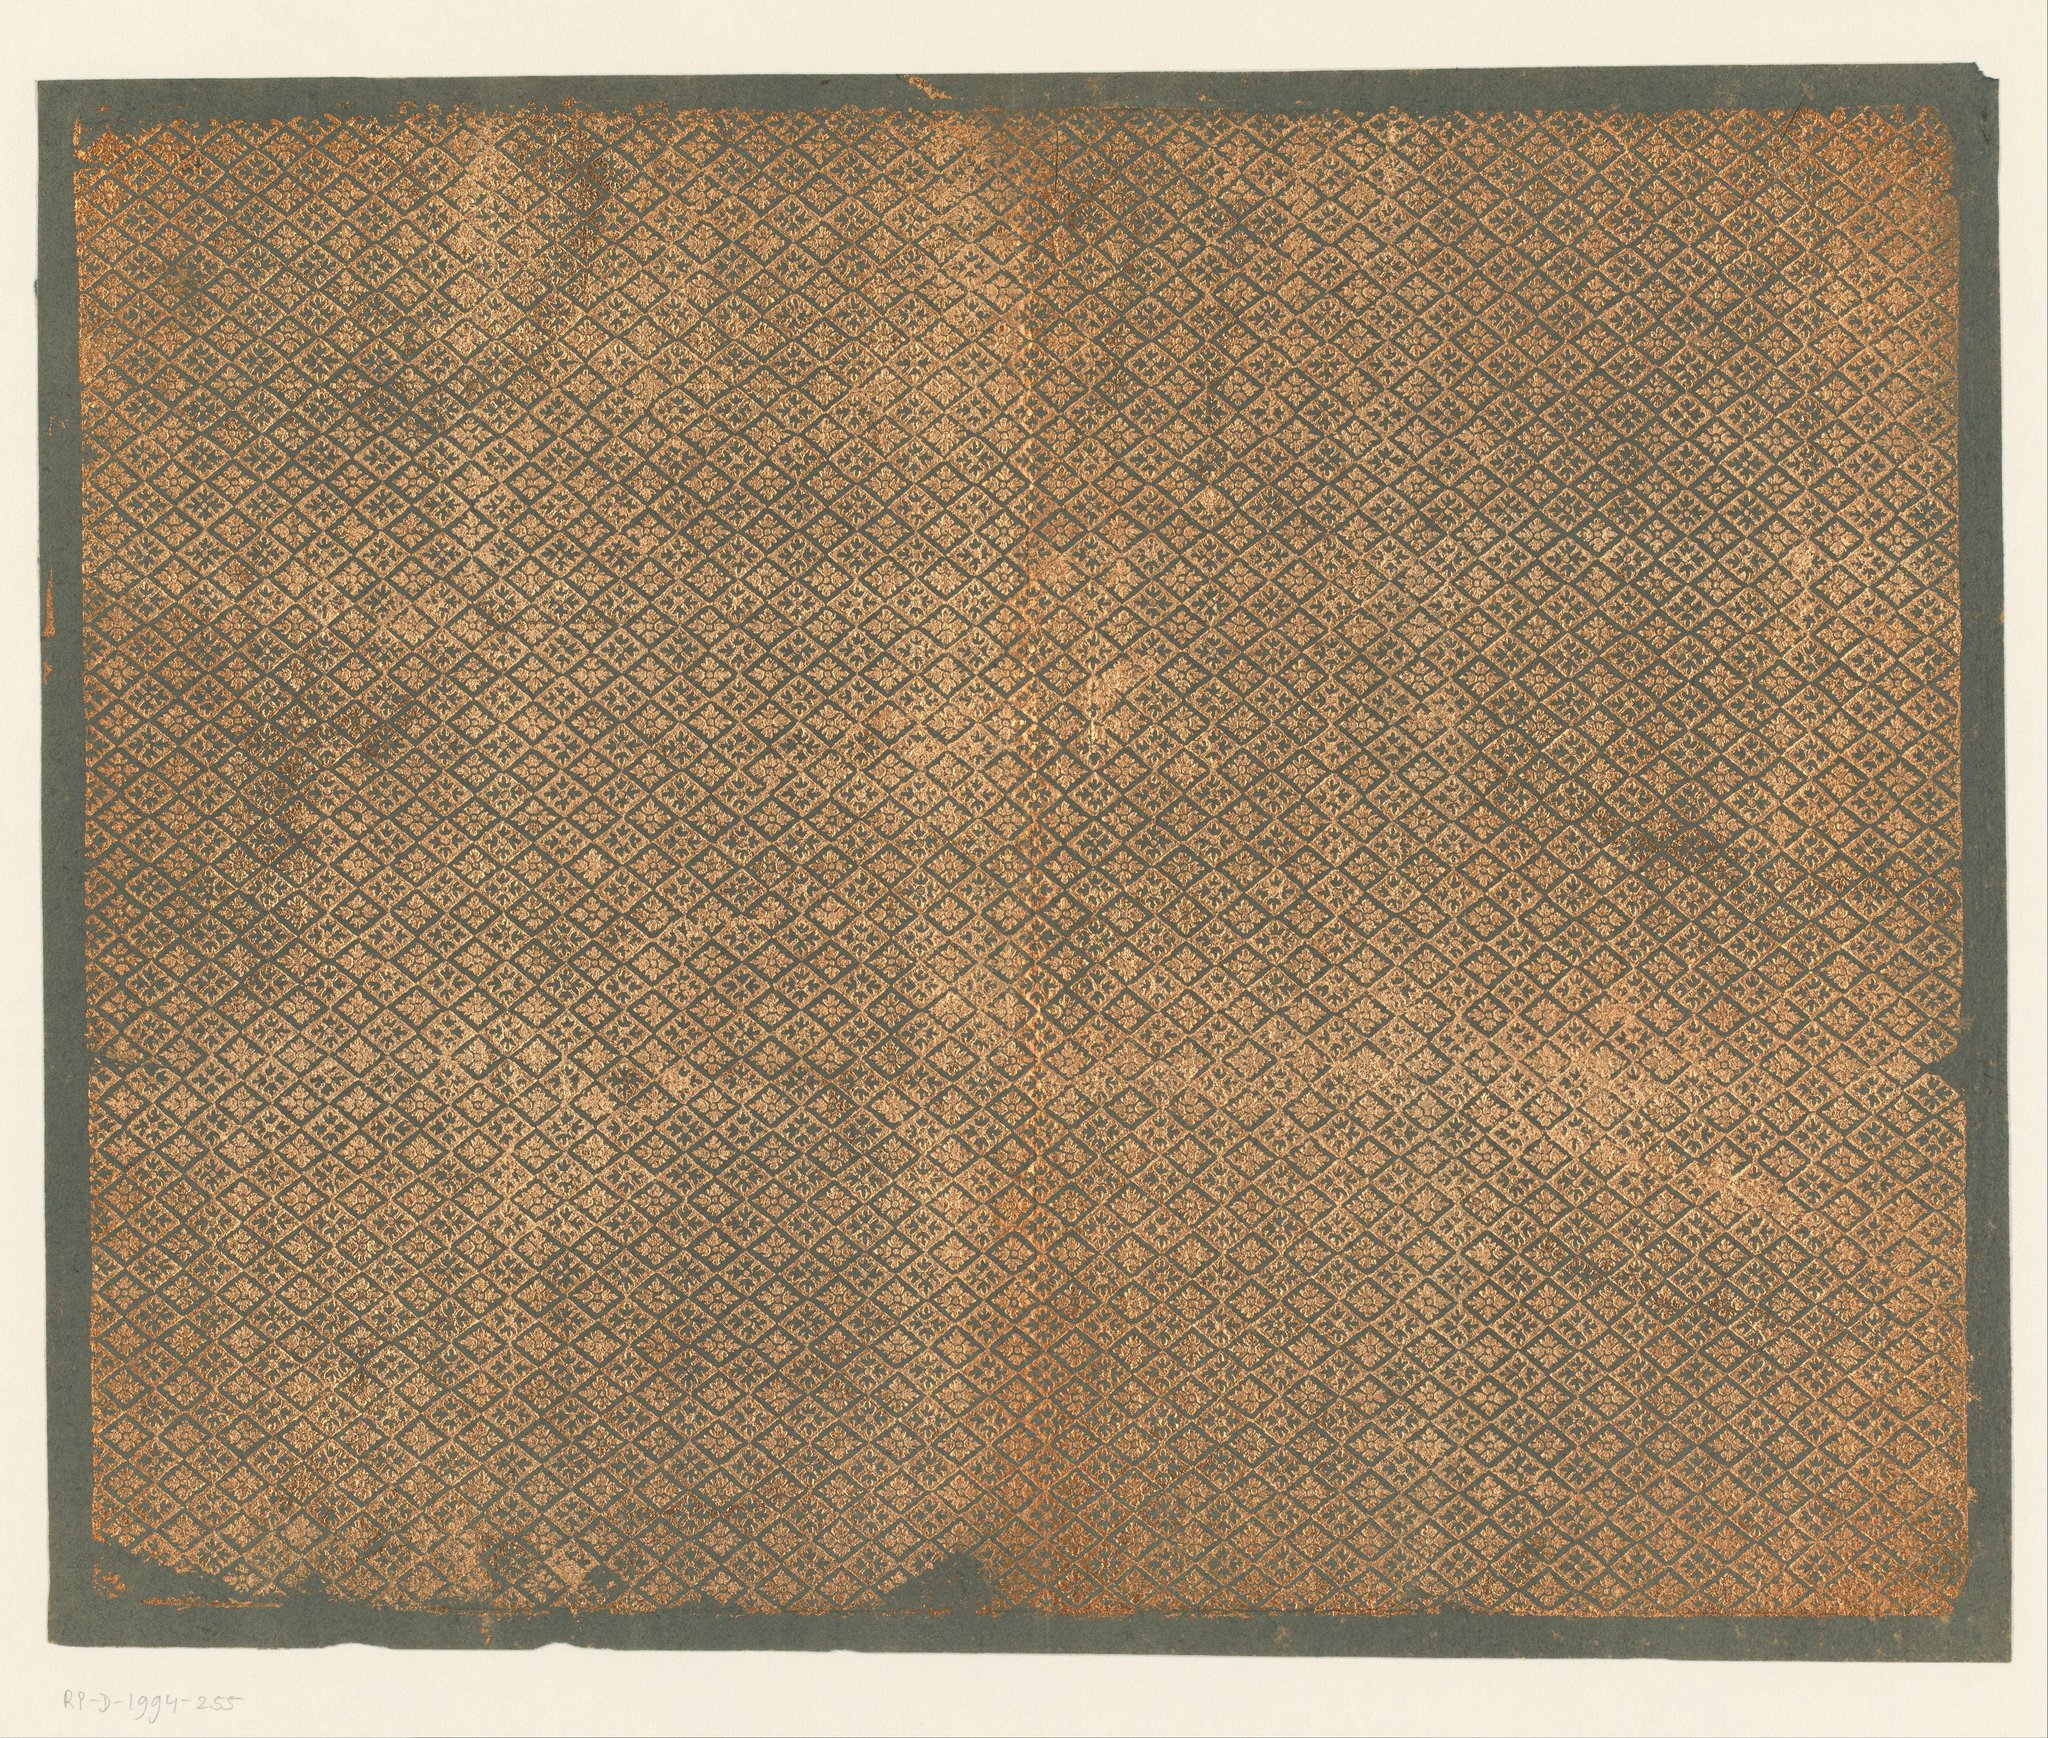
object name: brocade paper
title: Blad met ruitmotief gevuld met rozet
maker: Anonymous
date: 1750-1849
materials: gold leaf, paint, paper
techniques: relief print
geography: germany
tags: ornament ~ geometric motifs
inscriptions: collector's mark: Lugt 2228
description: Blad met ruitmotief gevuld met rozet, mogelijk gebruikt als omslag.